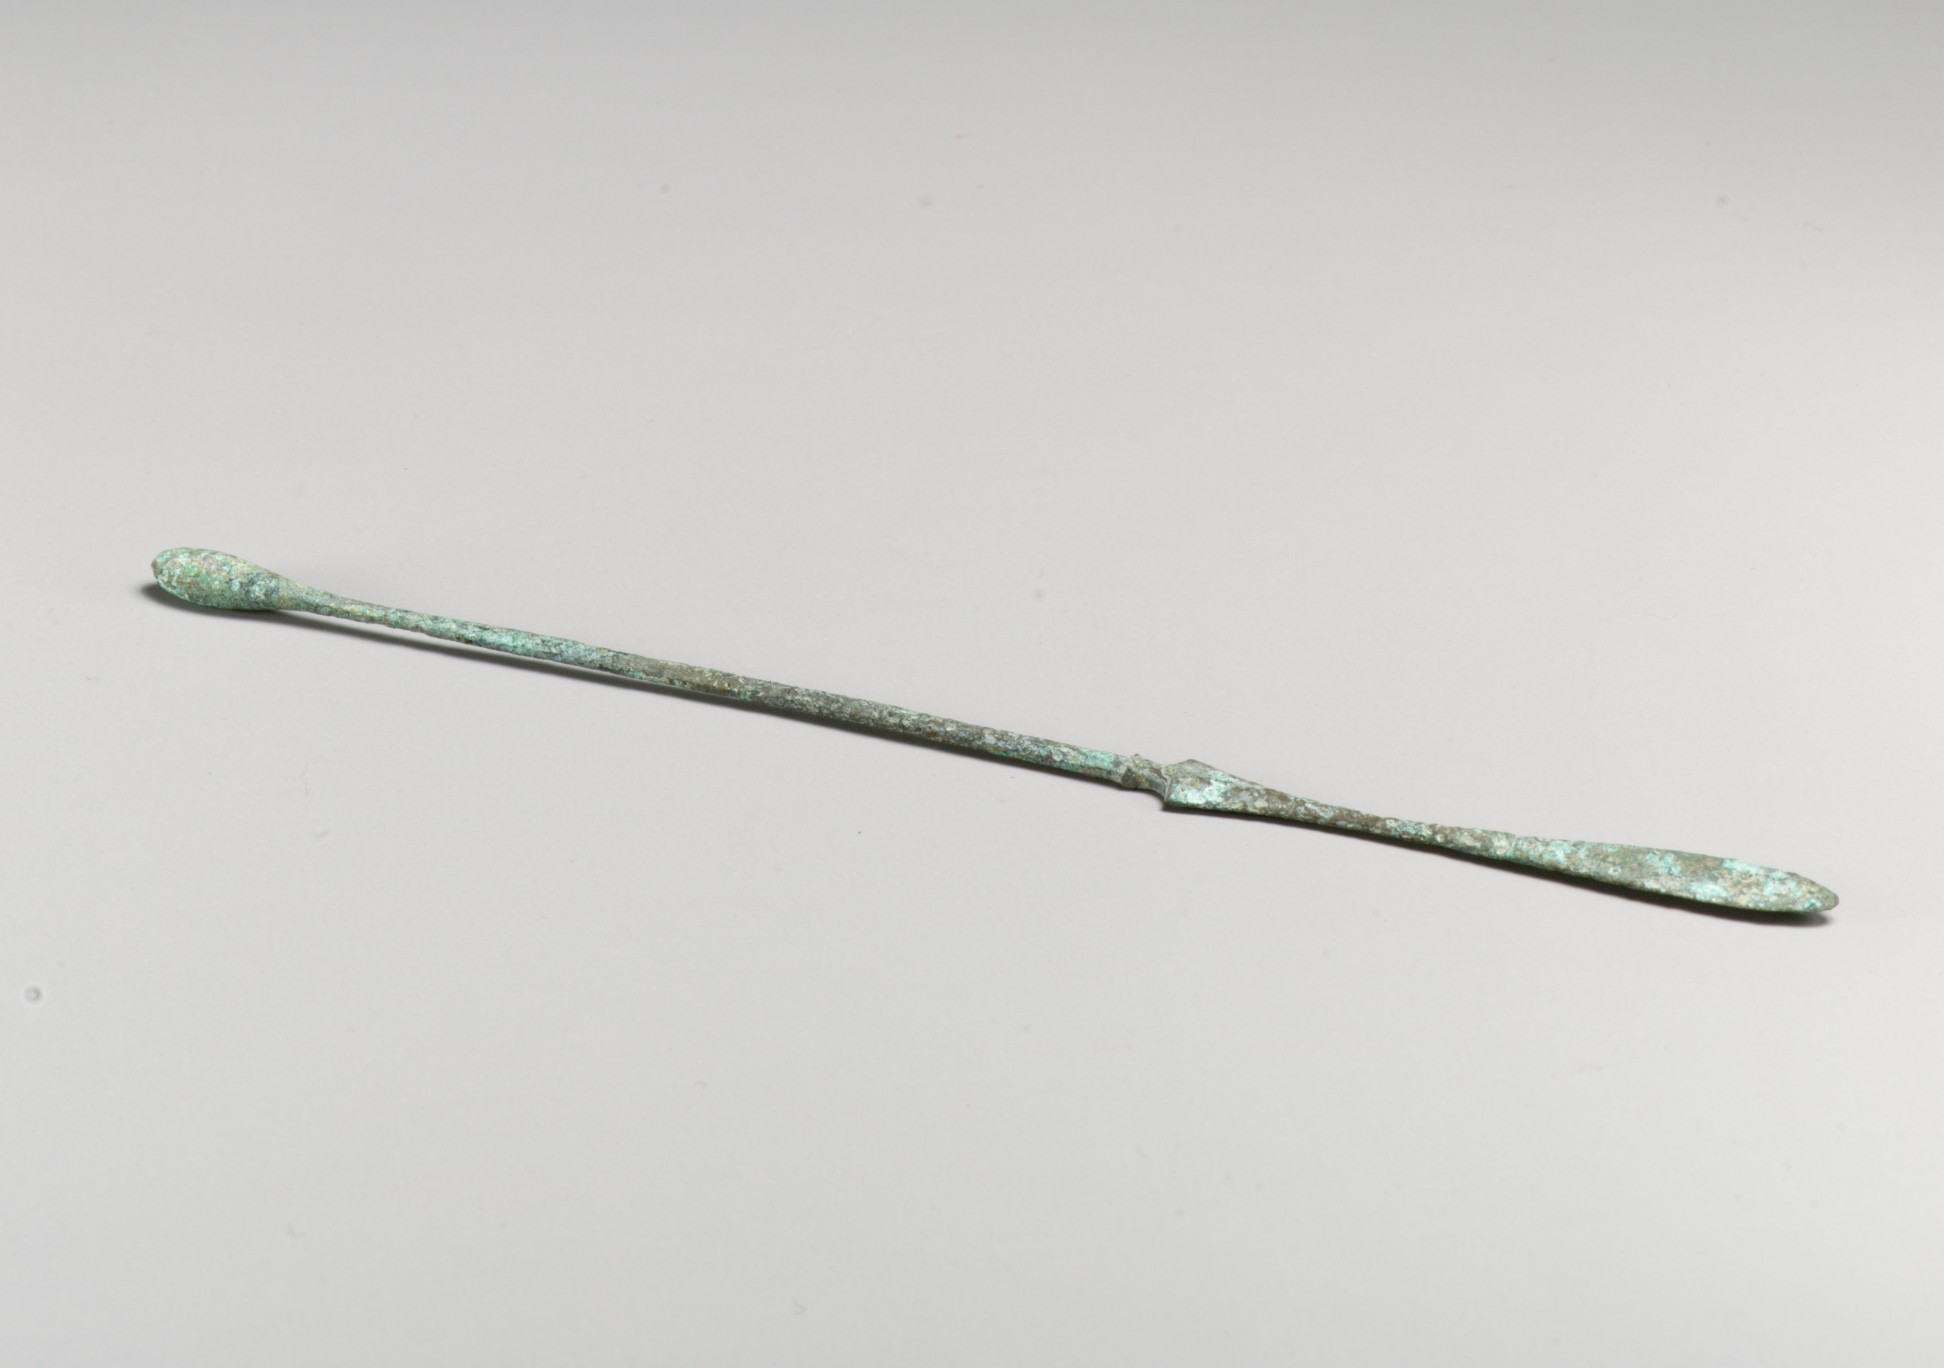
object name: spatula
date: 7000 BCE-330 CE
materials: bronze